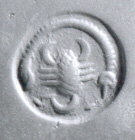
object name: stamp seal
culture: sasanian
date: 201-700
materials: lapis lazuli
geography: iran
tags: scorpions